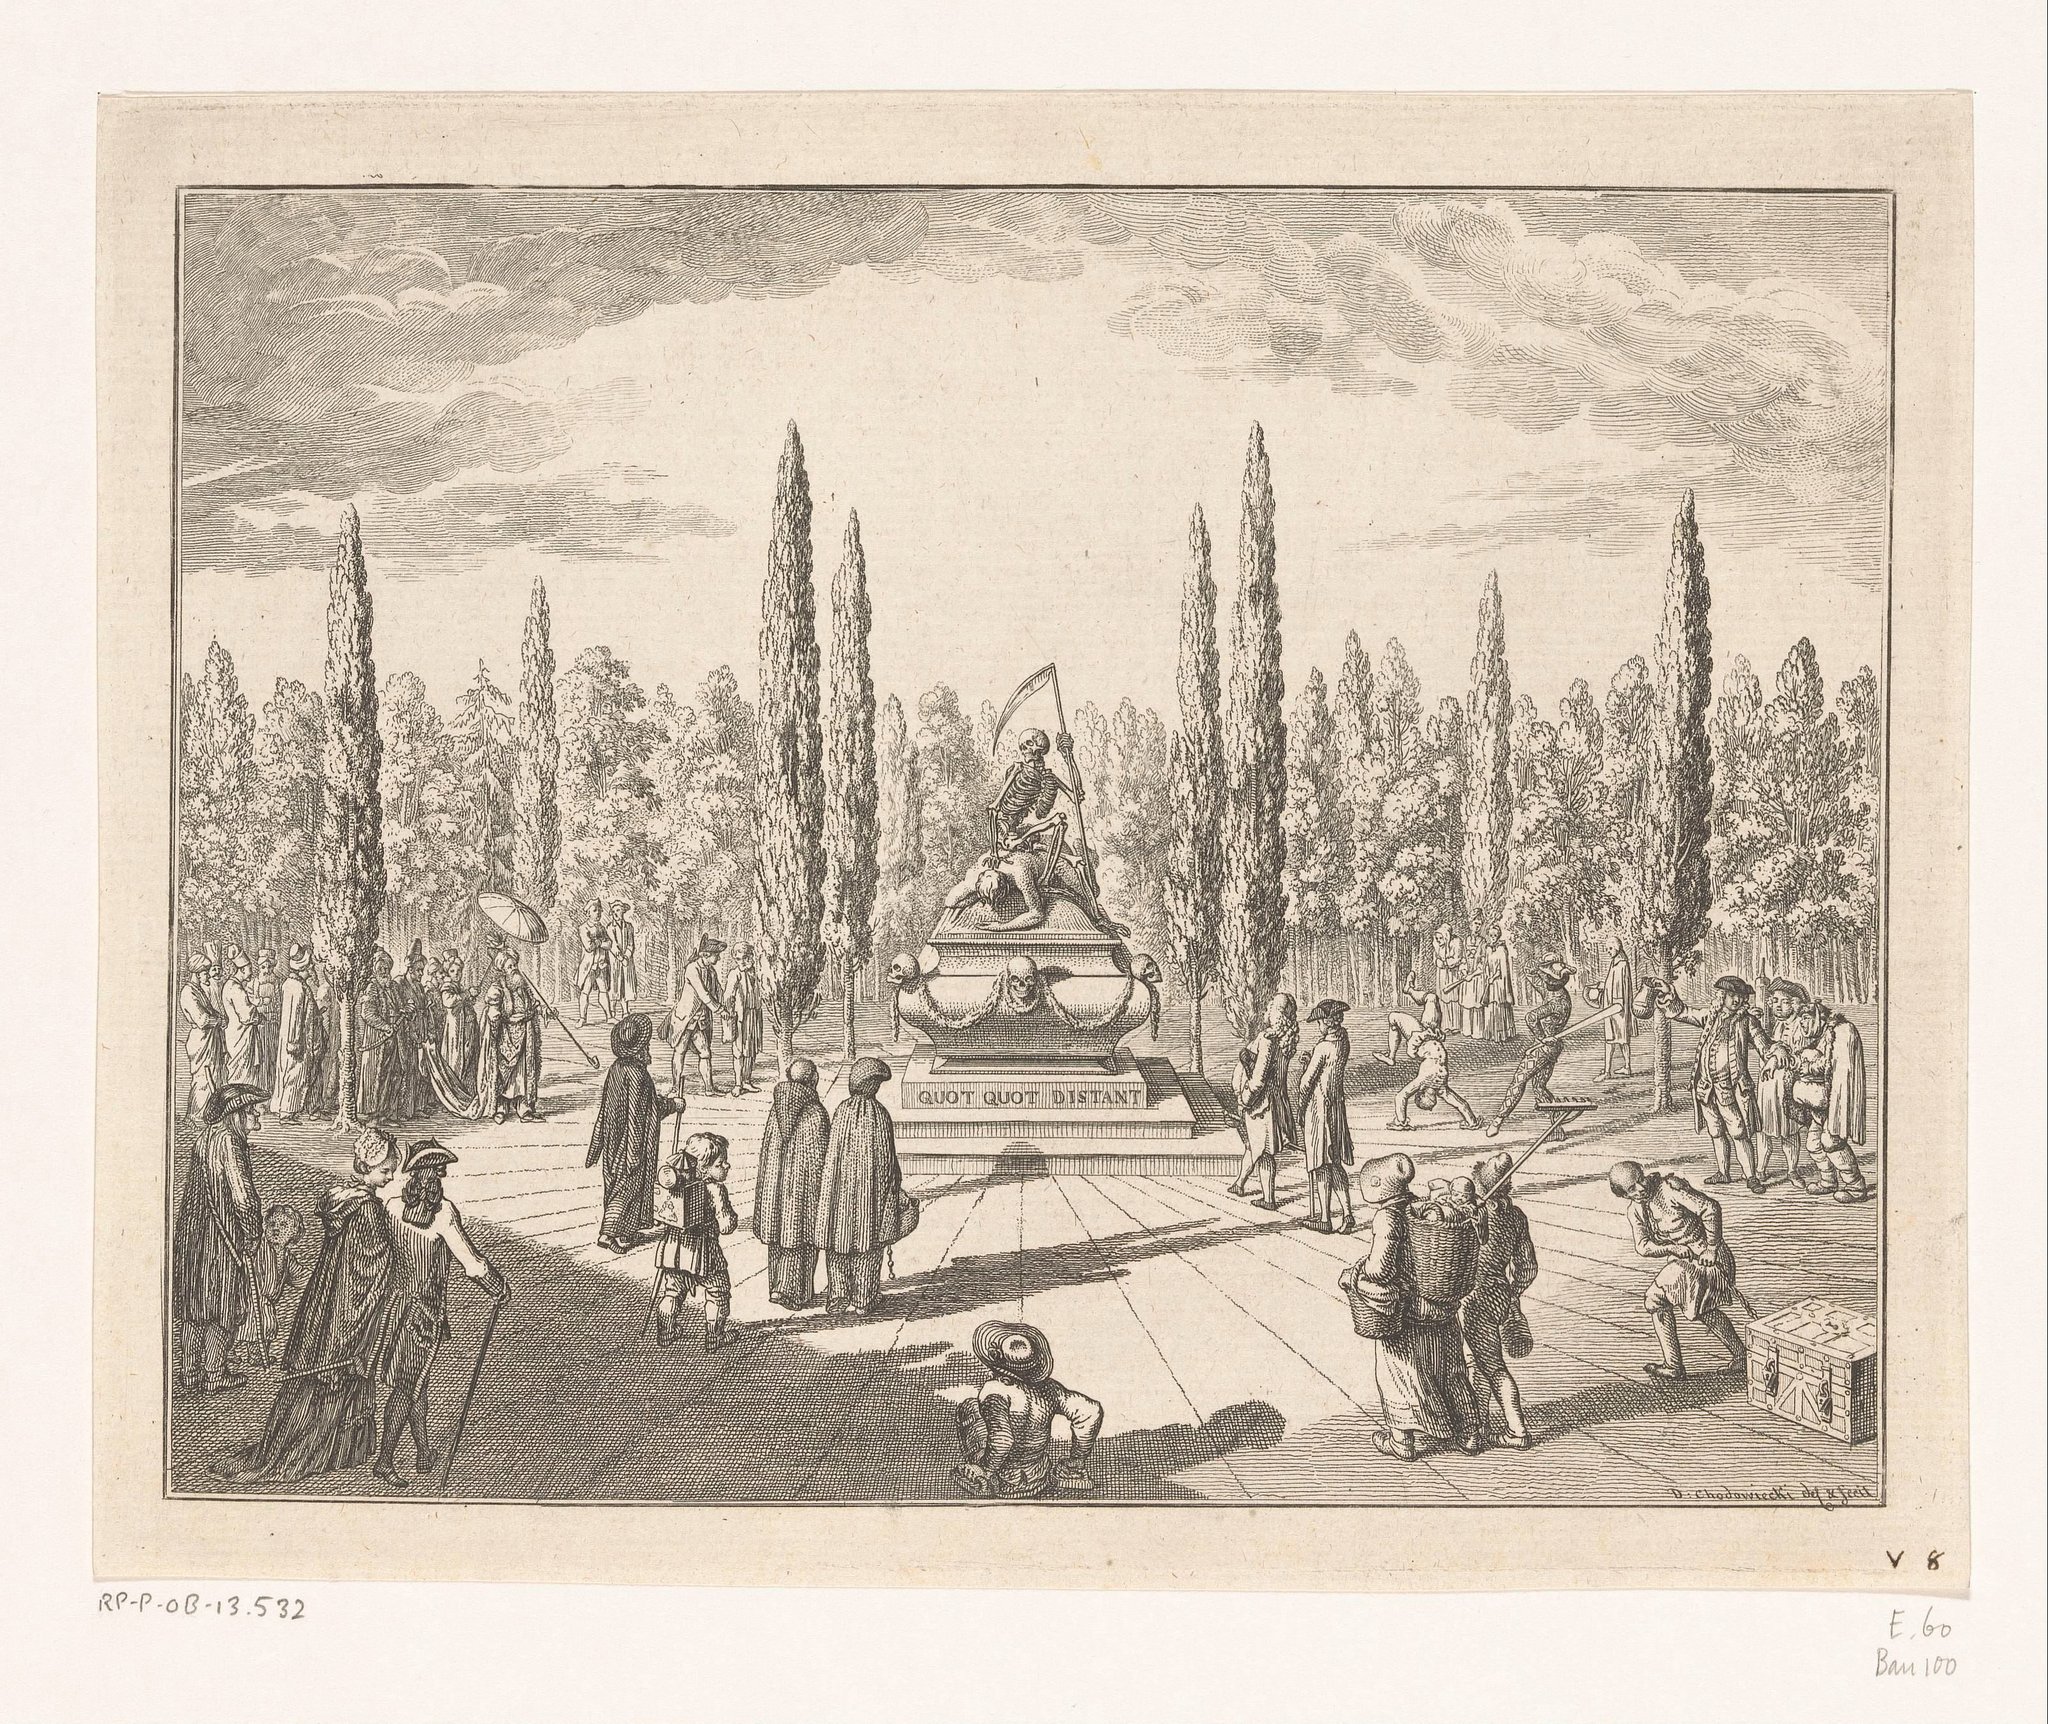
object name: print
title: Gelijkheid van alle standen in het graf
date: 1770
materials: paper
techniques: etching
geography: berlin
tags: death as skeleton (+ death with scythe), division into classes (~ society), grave-building, monumental tomb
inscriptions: inscription: ‘V S’, collector's mark: Lugt 240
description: Deze prent maakt onderdeel uit van vier prenten die Chodowiecki vervaardigde voor de herdenkingsrede voor Carolina Maria, weduwe van Godfried Adolf Daum. De opdrachtgever was haar schoonzoon, Johann Freiherr von Labes. Ook gebruikt als illustratie in: Porree, Johann Friedrich. Gedächtnisrede auf (...) Frau Carolina Maria verwittwete Daum, gebohrene Oloffen (...). Berlijn: gedrukt door Georg Jacob Decker, 1770.